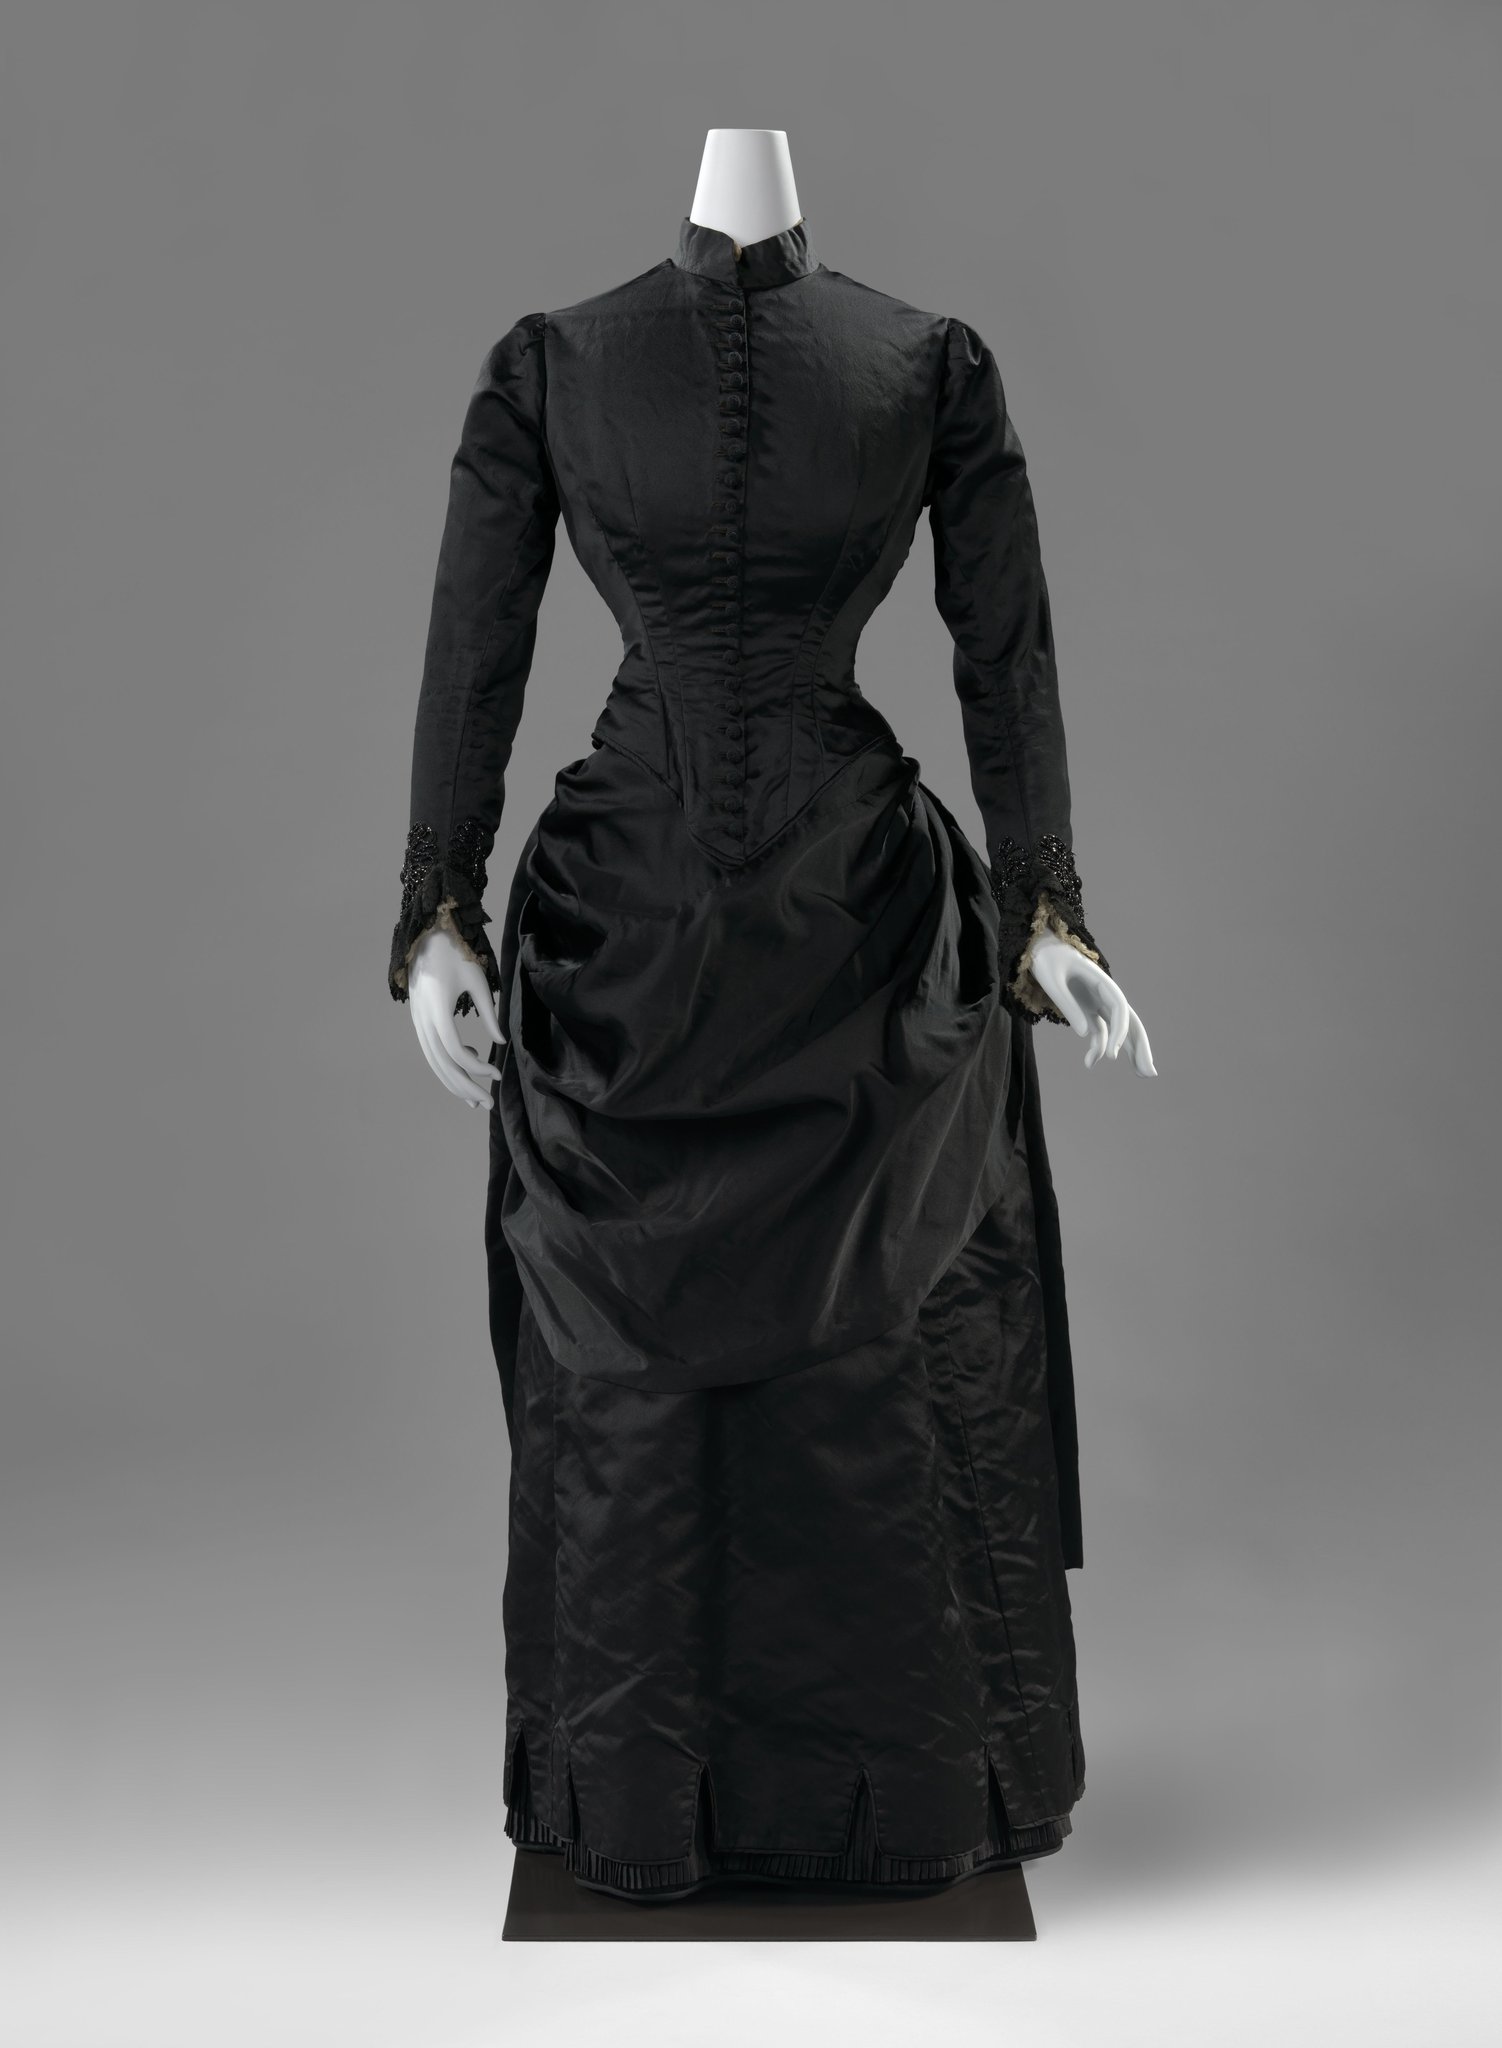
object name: womenswear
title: Lijfje van zwarte satijn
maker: w. wildermann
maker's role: kleermaker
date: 1885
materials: jet, silk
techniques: lace, cutting, pleated, weave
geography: karlsruhe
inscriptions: name: ‘W. WILDEMANN/ Damenkleidermacherin/ Karlsruhe’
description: Gestilleerd lijf met diepe punten middenvoor en -achter. Agrementknoopjes van voren, hooggesloten hals met een boordje. Gitten ornament onderaan de mouwen, waar een strook kant afhangt. In de mouwstroken en boord een witgazen ruche. Lijfje is onderdeel van een trouwjapon (BK-1961-105).